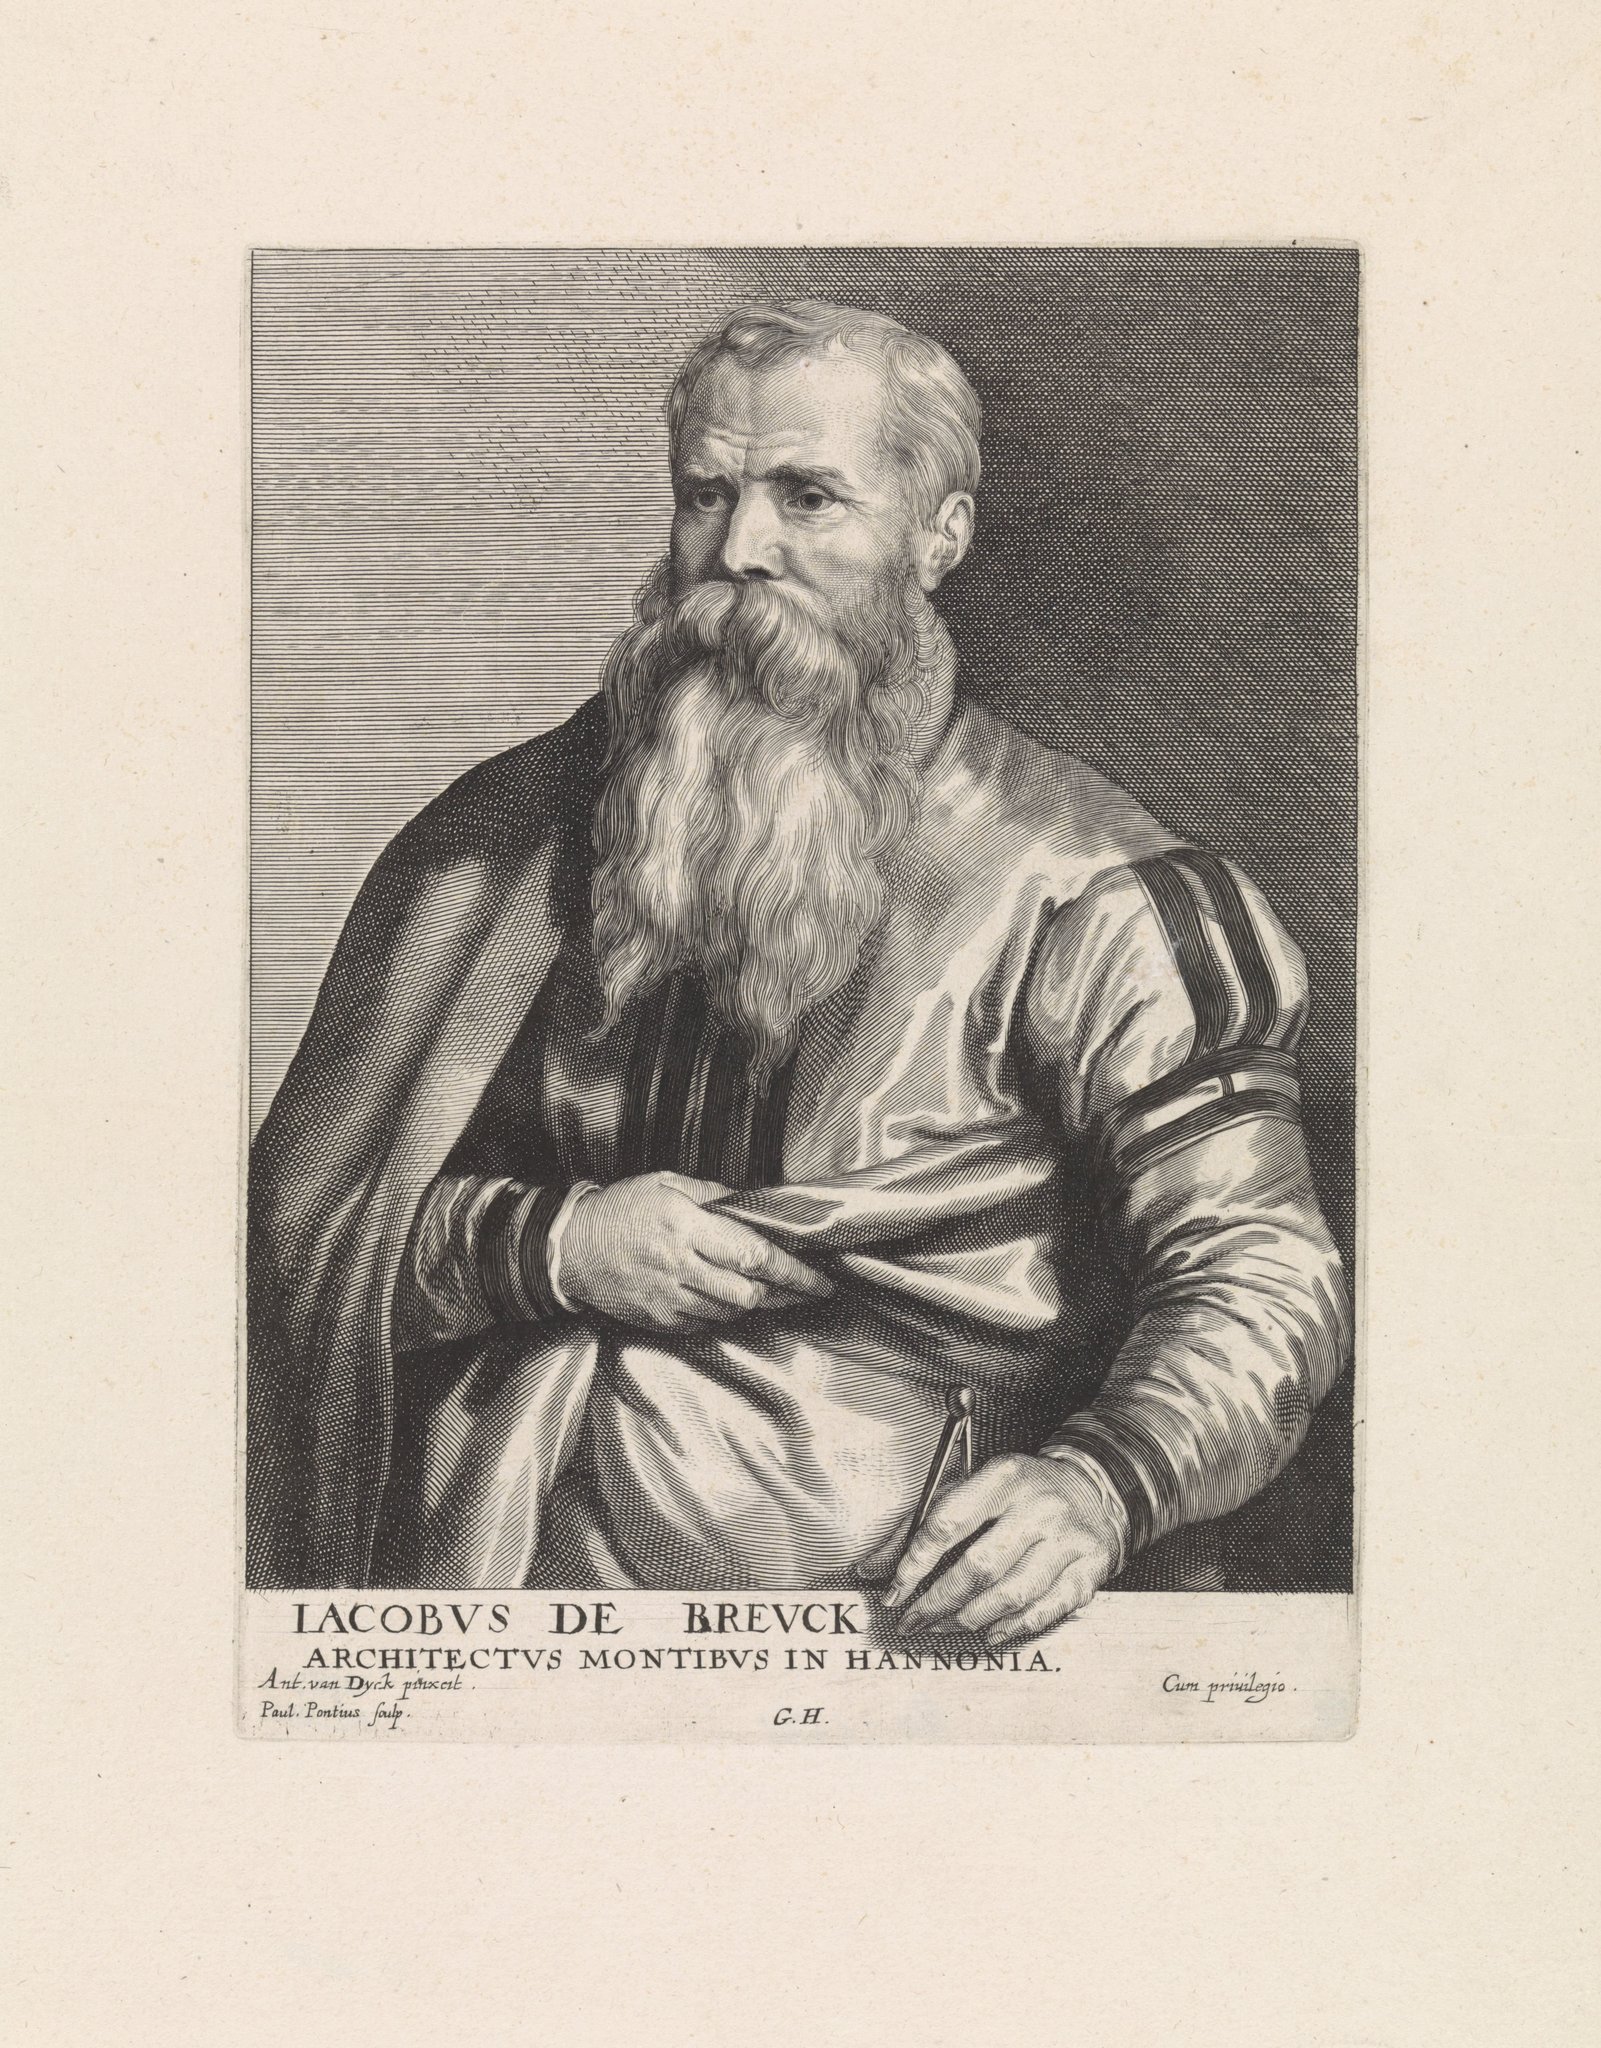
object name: print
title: Portret van de architect Jacob de Breuck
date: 1616-1657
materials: paper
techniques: engraving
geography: antwerp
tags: sculptor, compasses, portrait, self-portrait of architect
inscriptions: collector's mark: Lugt 2166, collector's mark: Lugt 2760, collector's mark: Lugt 2228